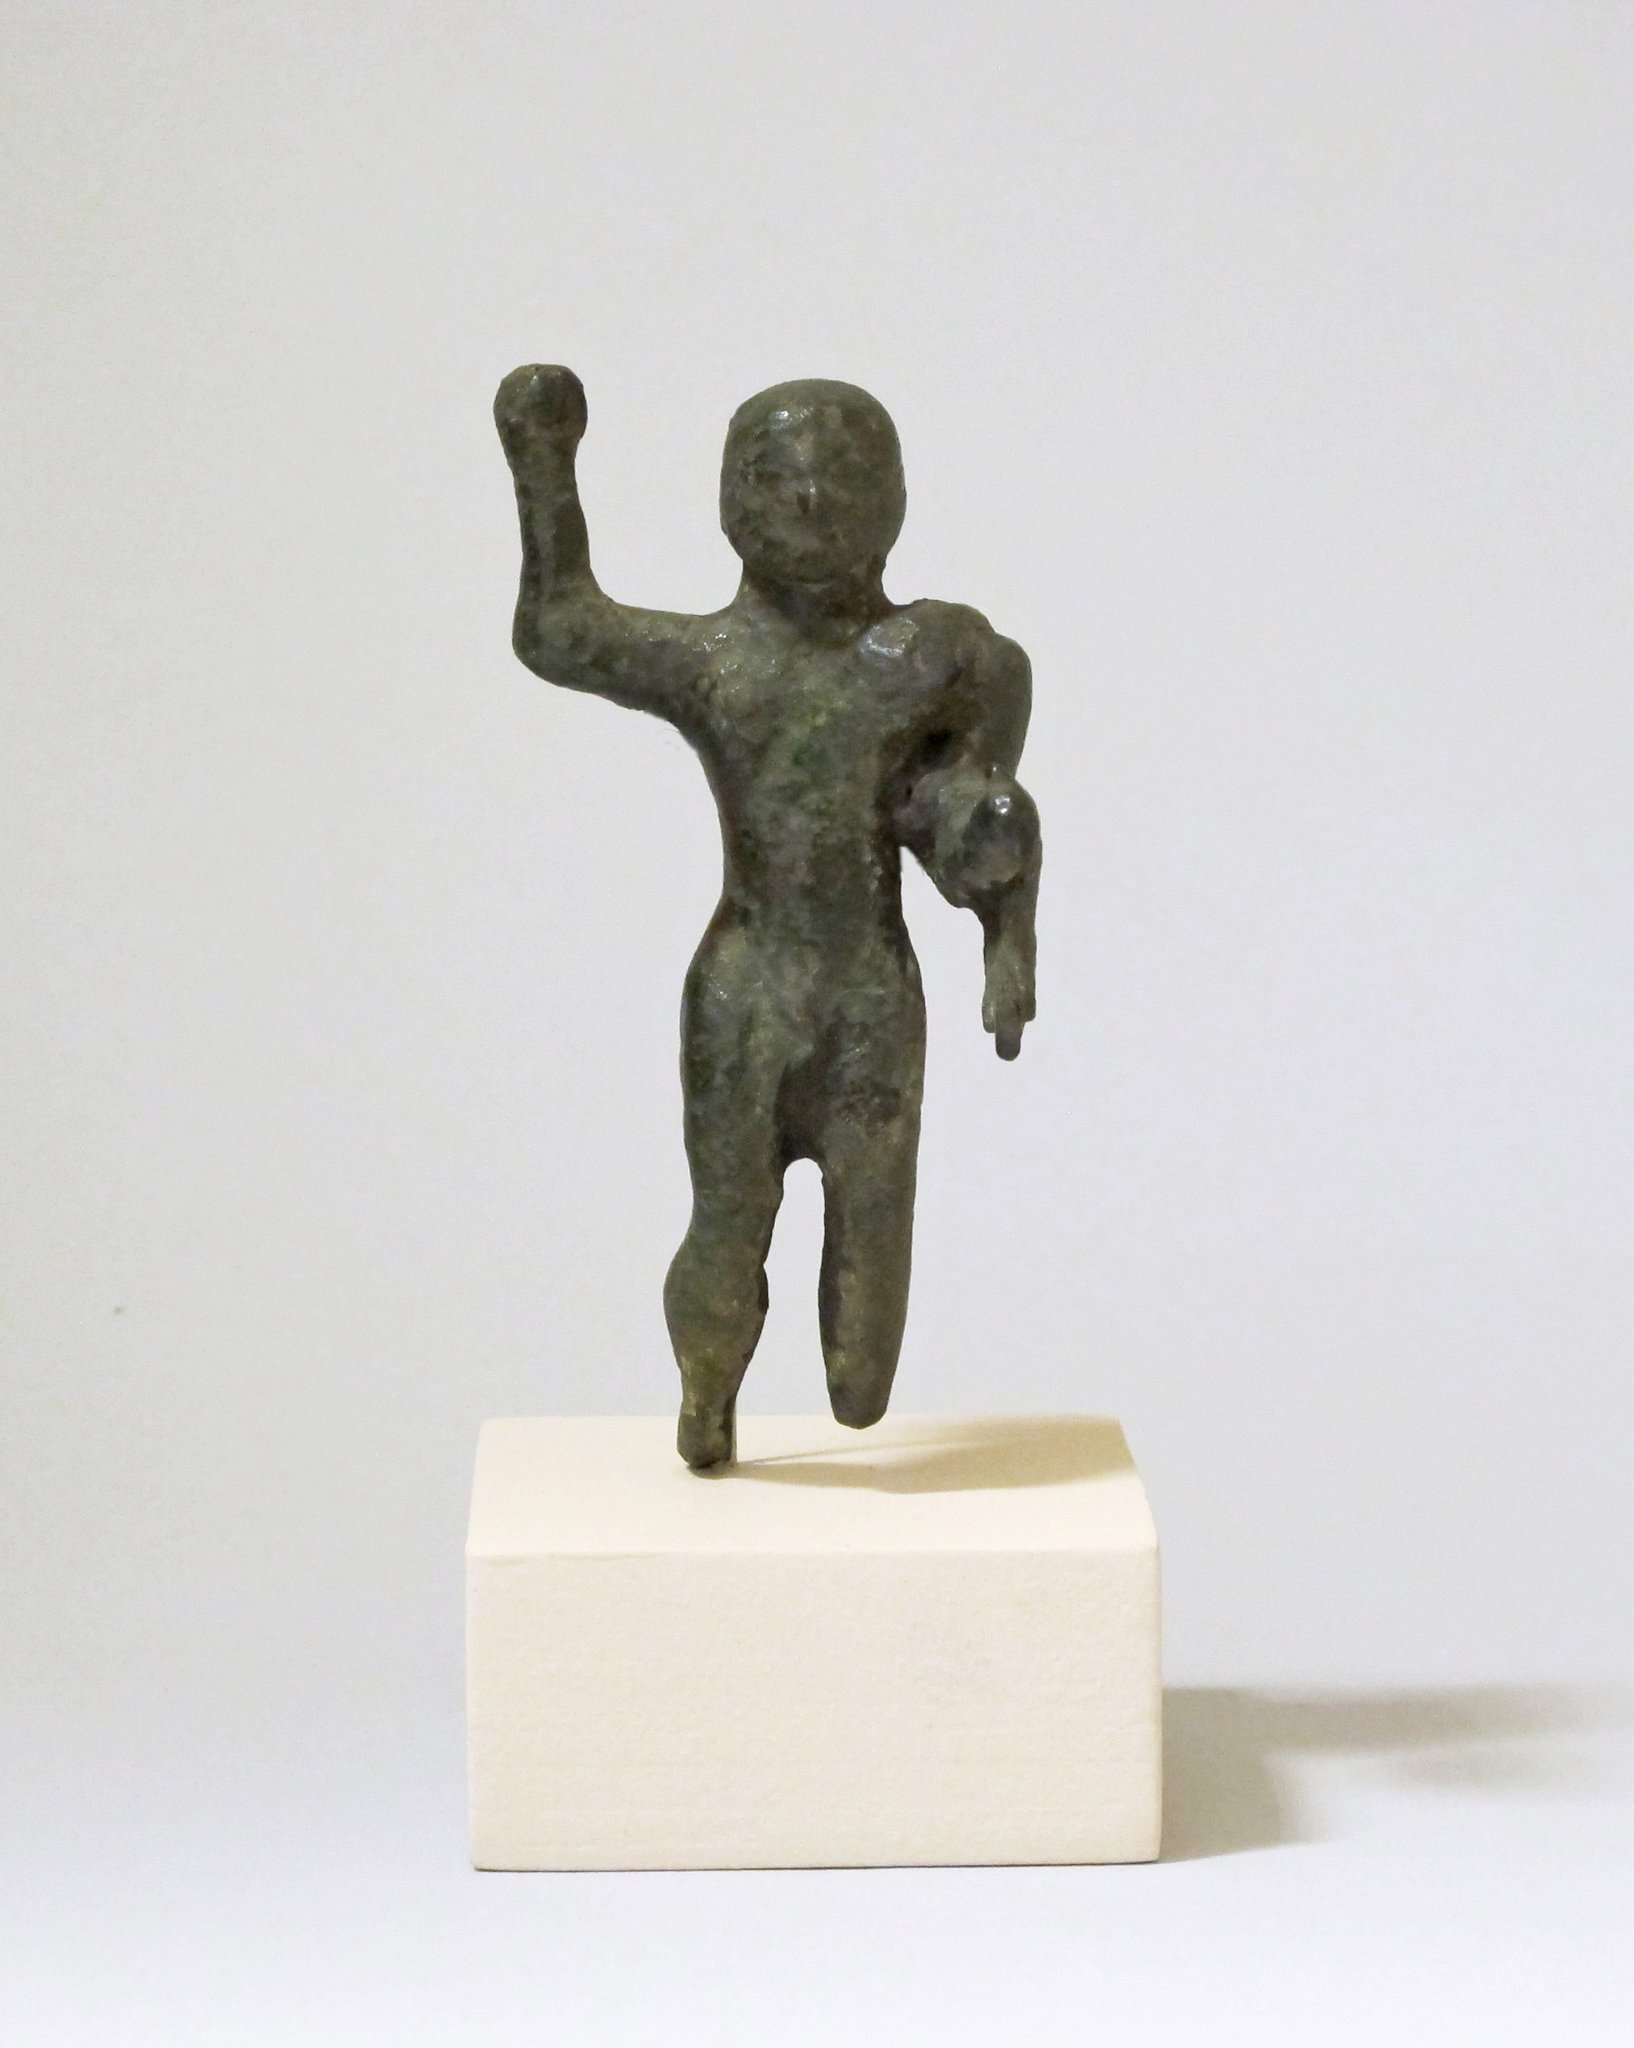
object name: statuette of herakles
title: Bronze statuette of Herakles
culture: italic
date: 500-301 BCE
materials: bronze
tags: herakles